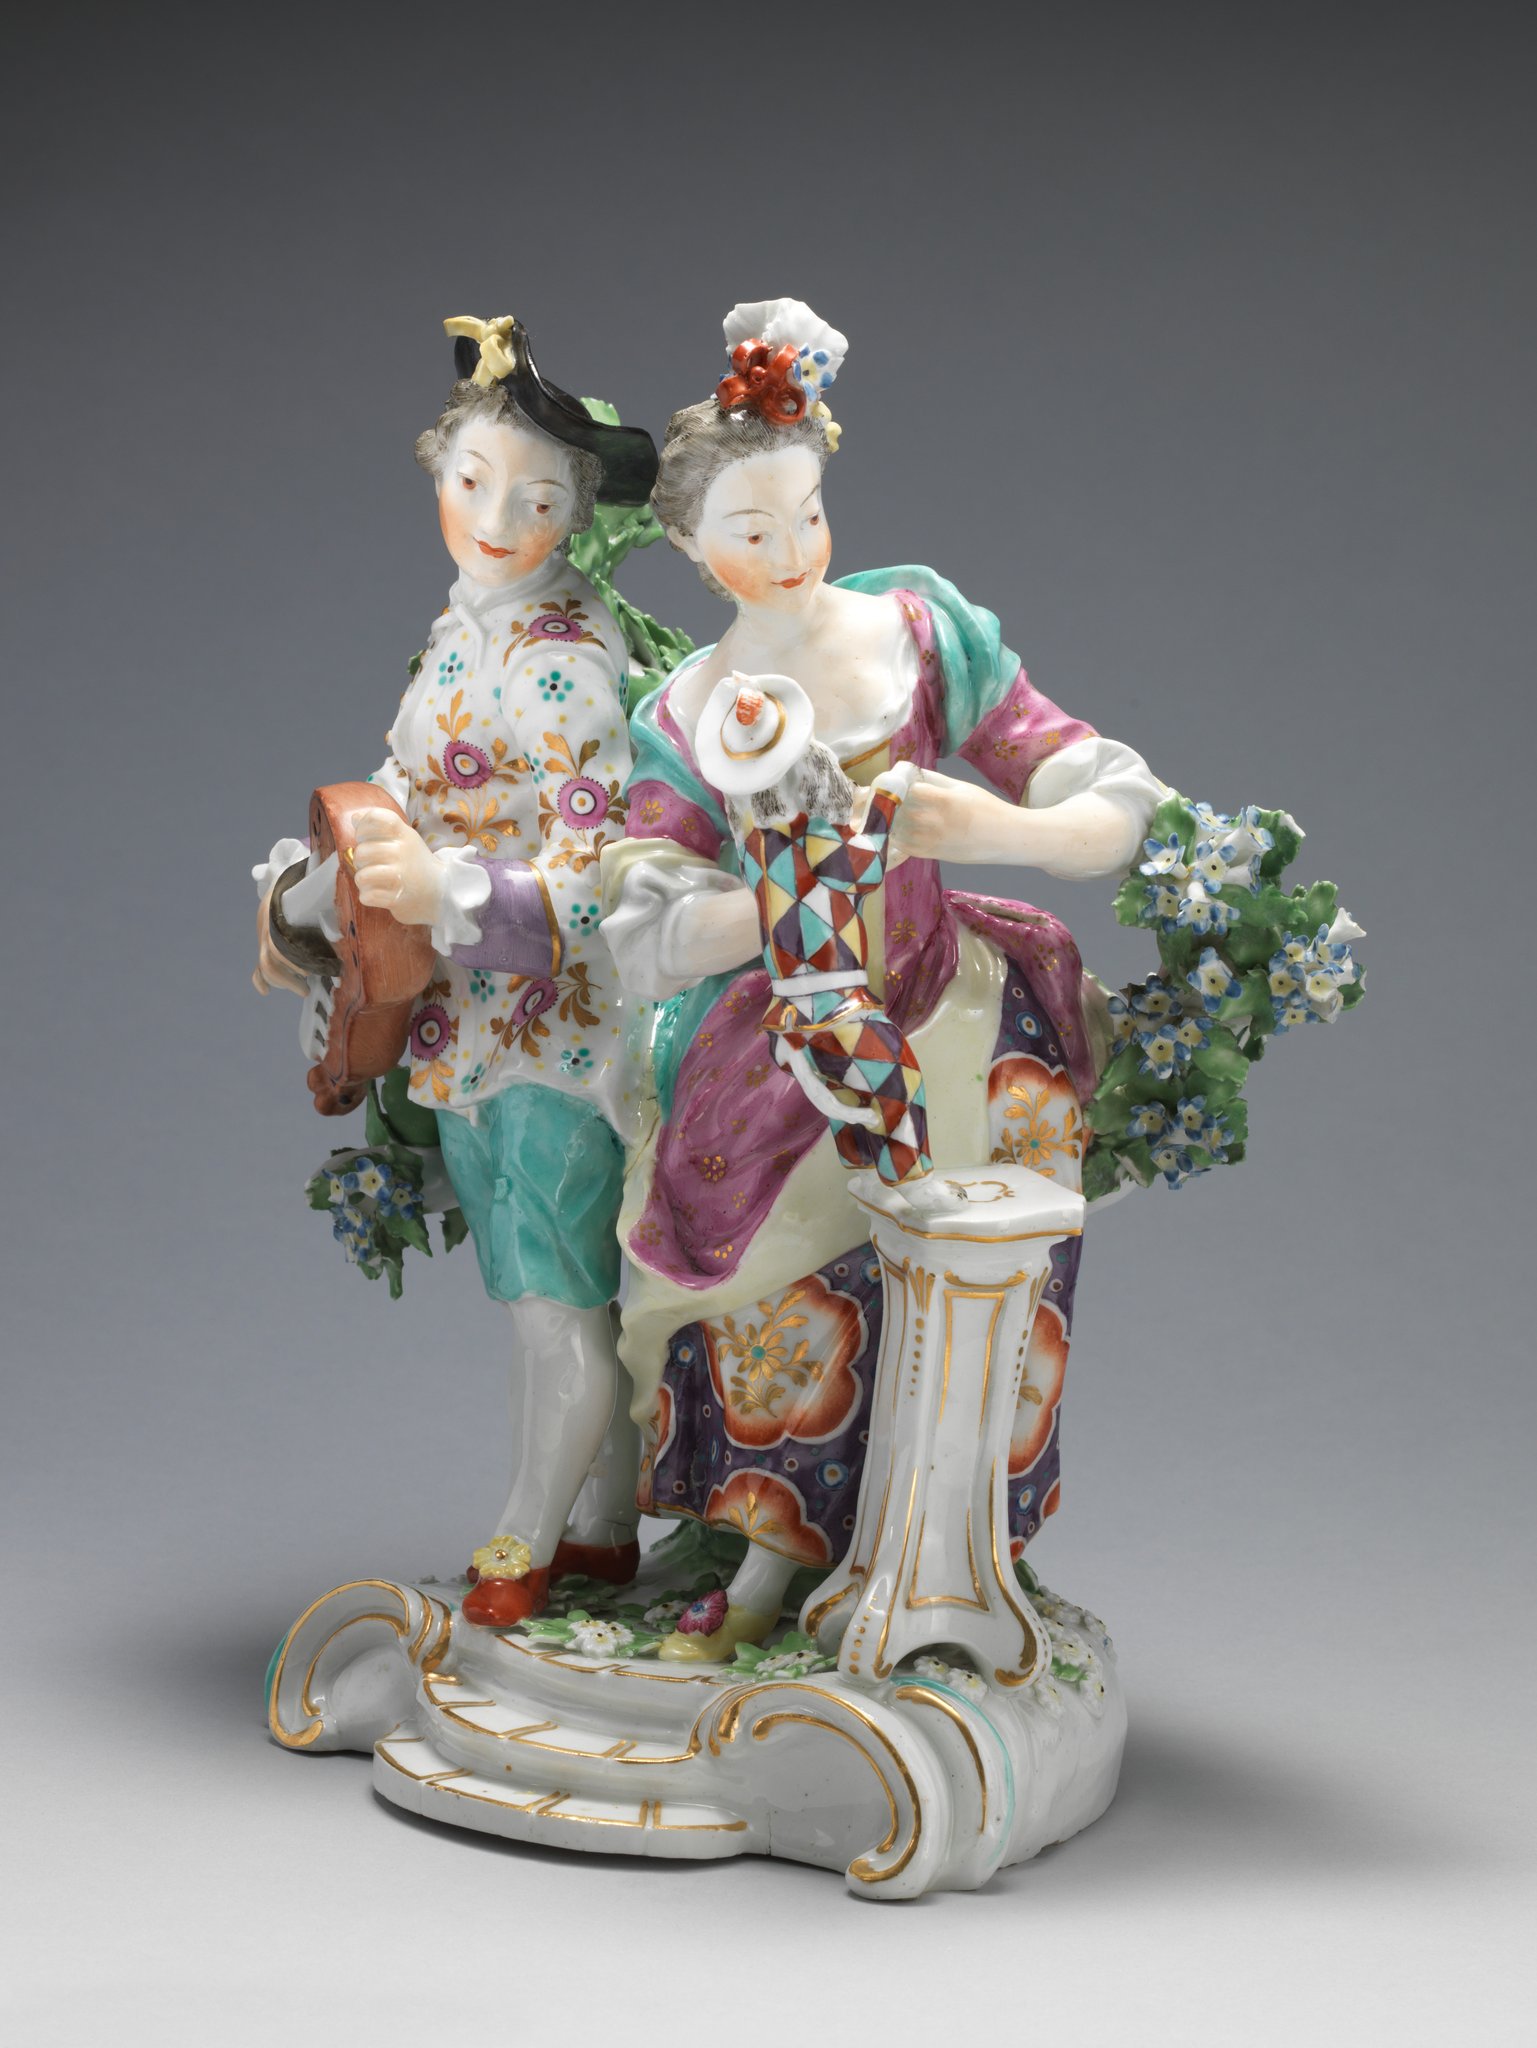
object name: group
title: Youth playing hurdy-gurdy, girl teaching dog dressed as harlequin to dance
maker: derby porcelain manufactory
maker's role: factory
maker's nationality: british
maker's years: 1751-1785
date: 1765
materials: soft paste porcelain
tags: musical instruments,men,women,dogs